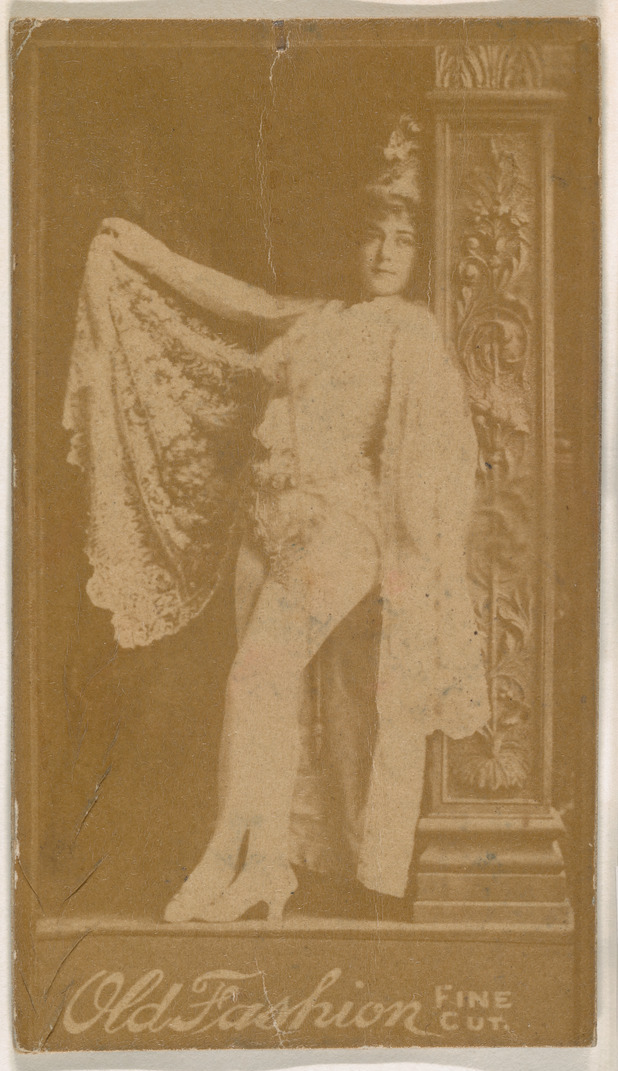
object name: photograph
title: Actress leaning against column, from the Actresses series (N664) promoting Old Fashion Fine Cut Tobacco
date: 1888-1890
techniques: albumen silver print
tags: portraits,women,actresses